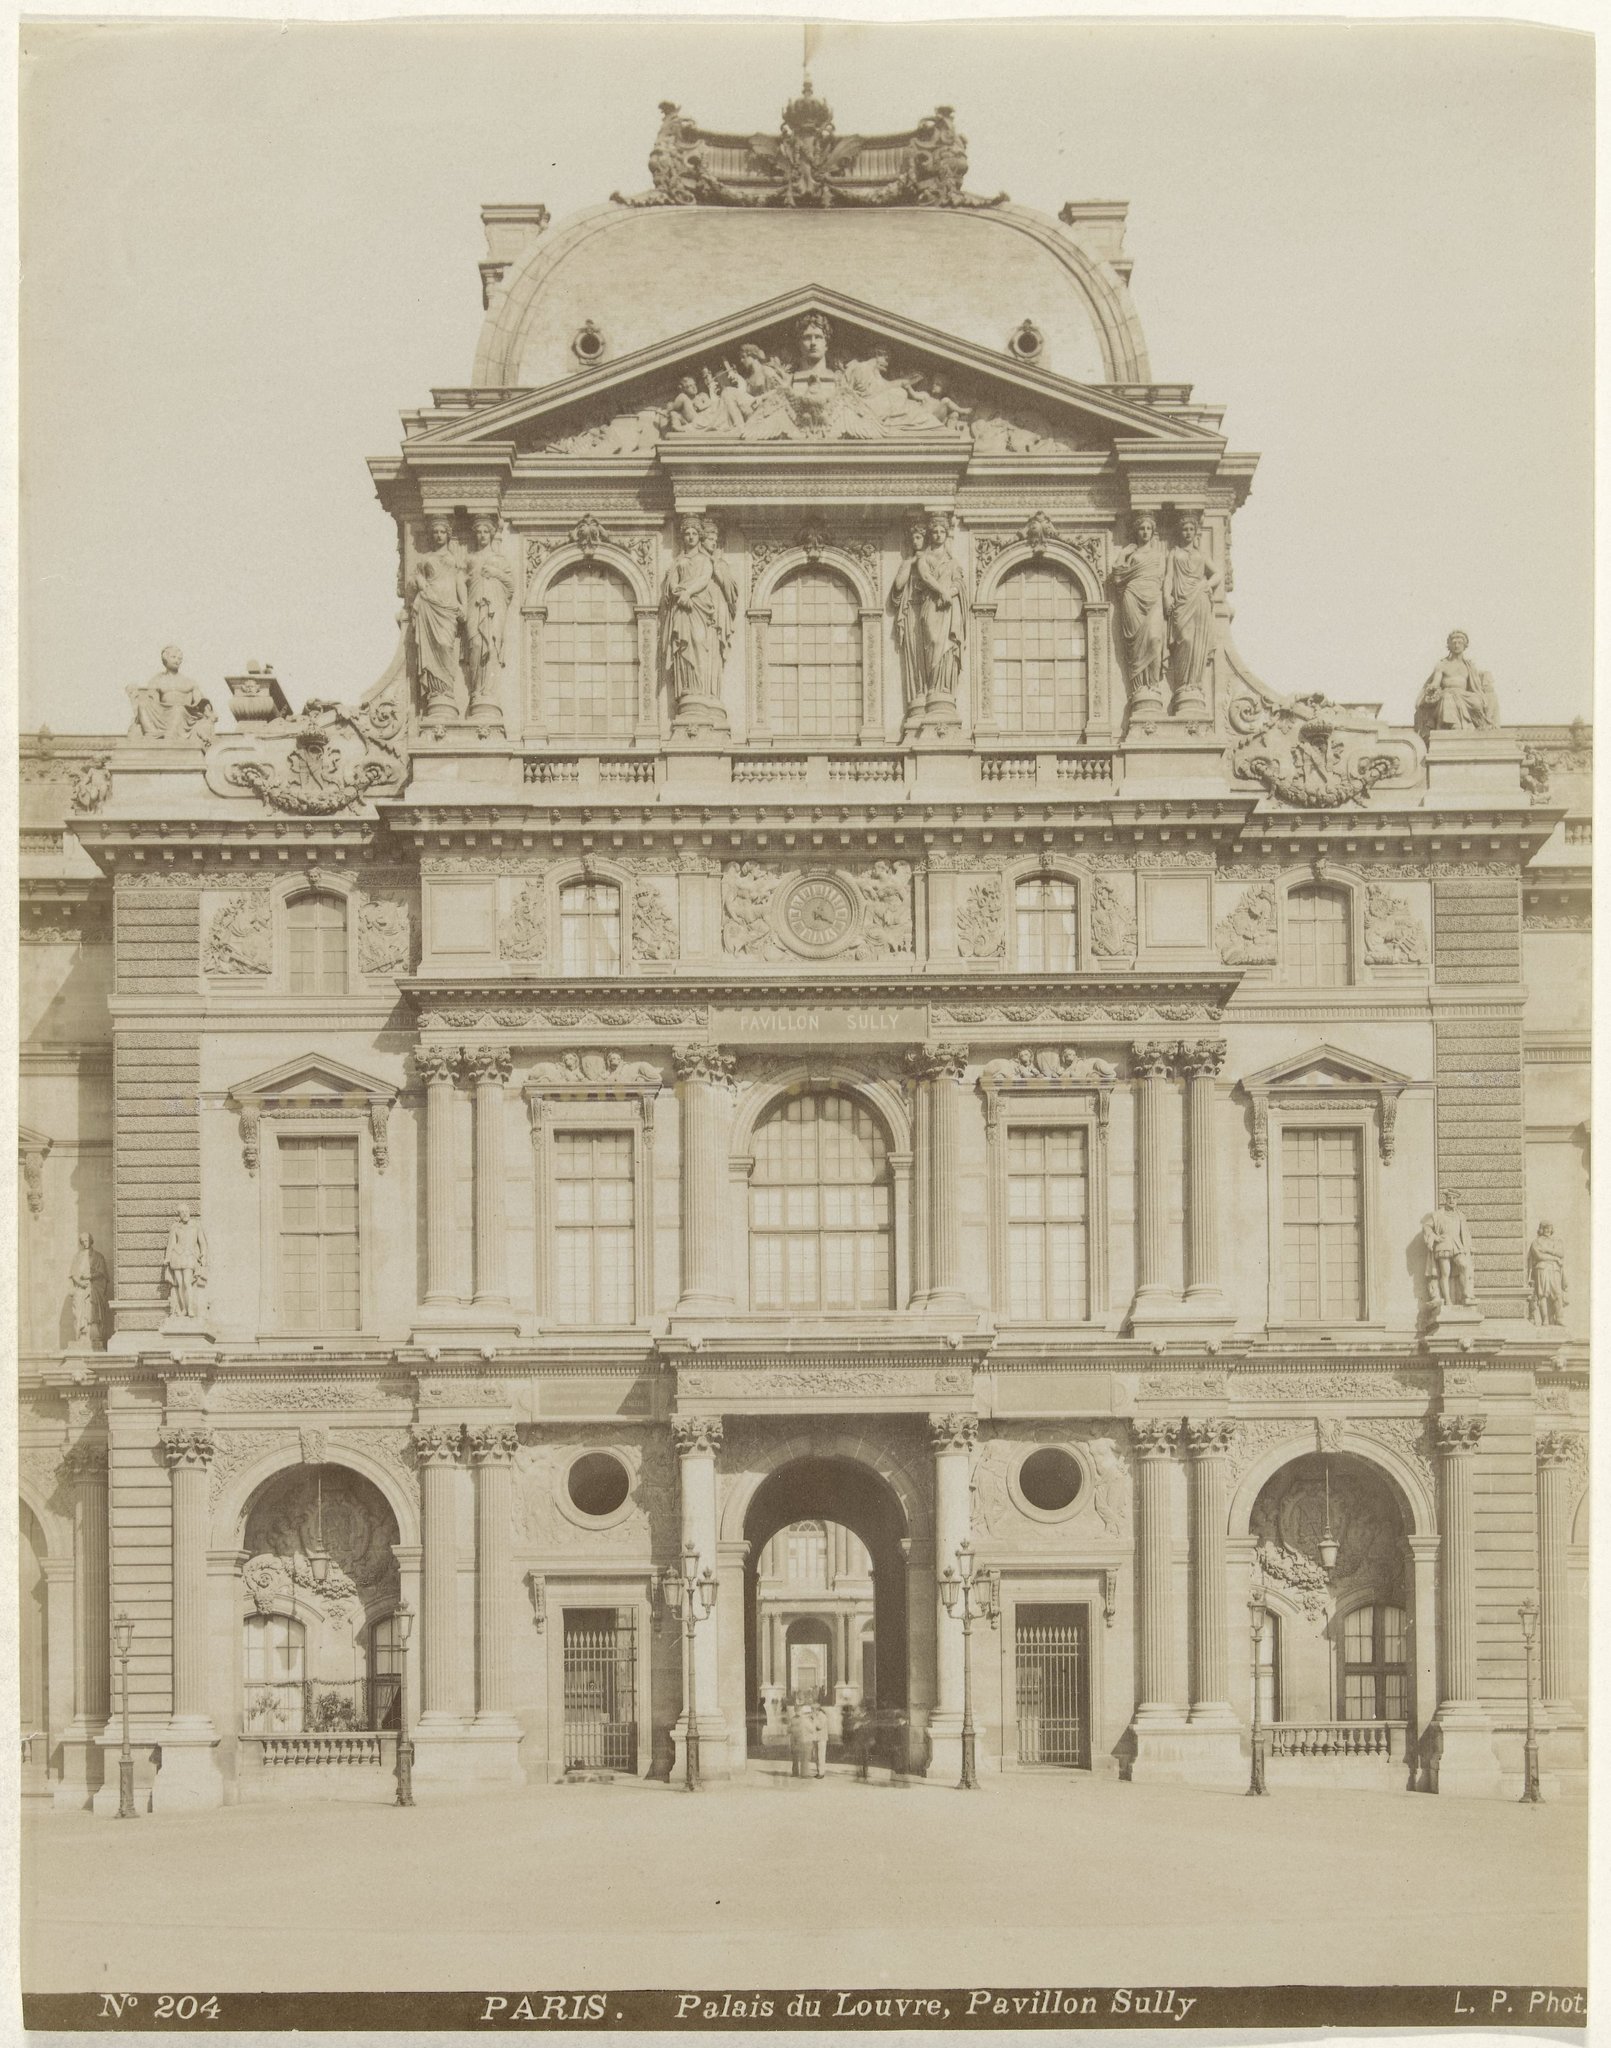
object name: photograph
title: Paviljoen Sully van het Louvre, Parijs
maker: louis antoine pamard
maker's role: fotograaf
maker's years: 1840-1893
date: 1870-1900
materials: cardboard, paper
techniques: albumen print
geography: france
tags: permanent exhibition, museum, exterior ~ representation of a building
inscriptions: number: ‘14’, number: ‘No 204’